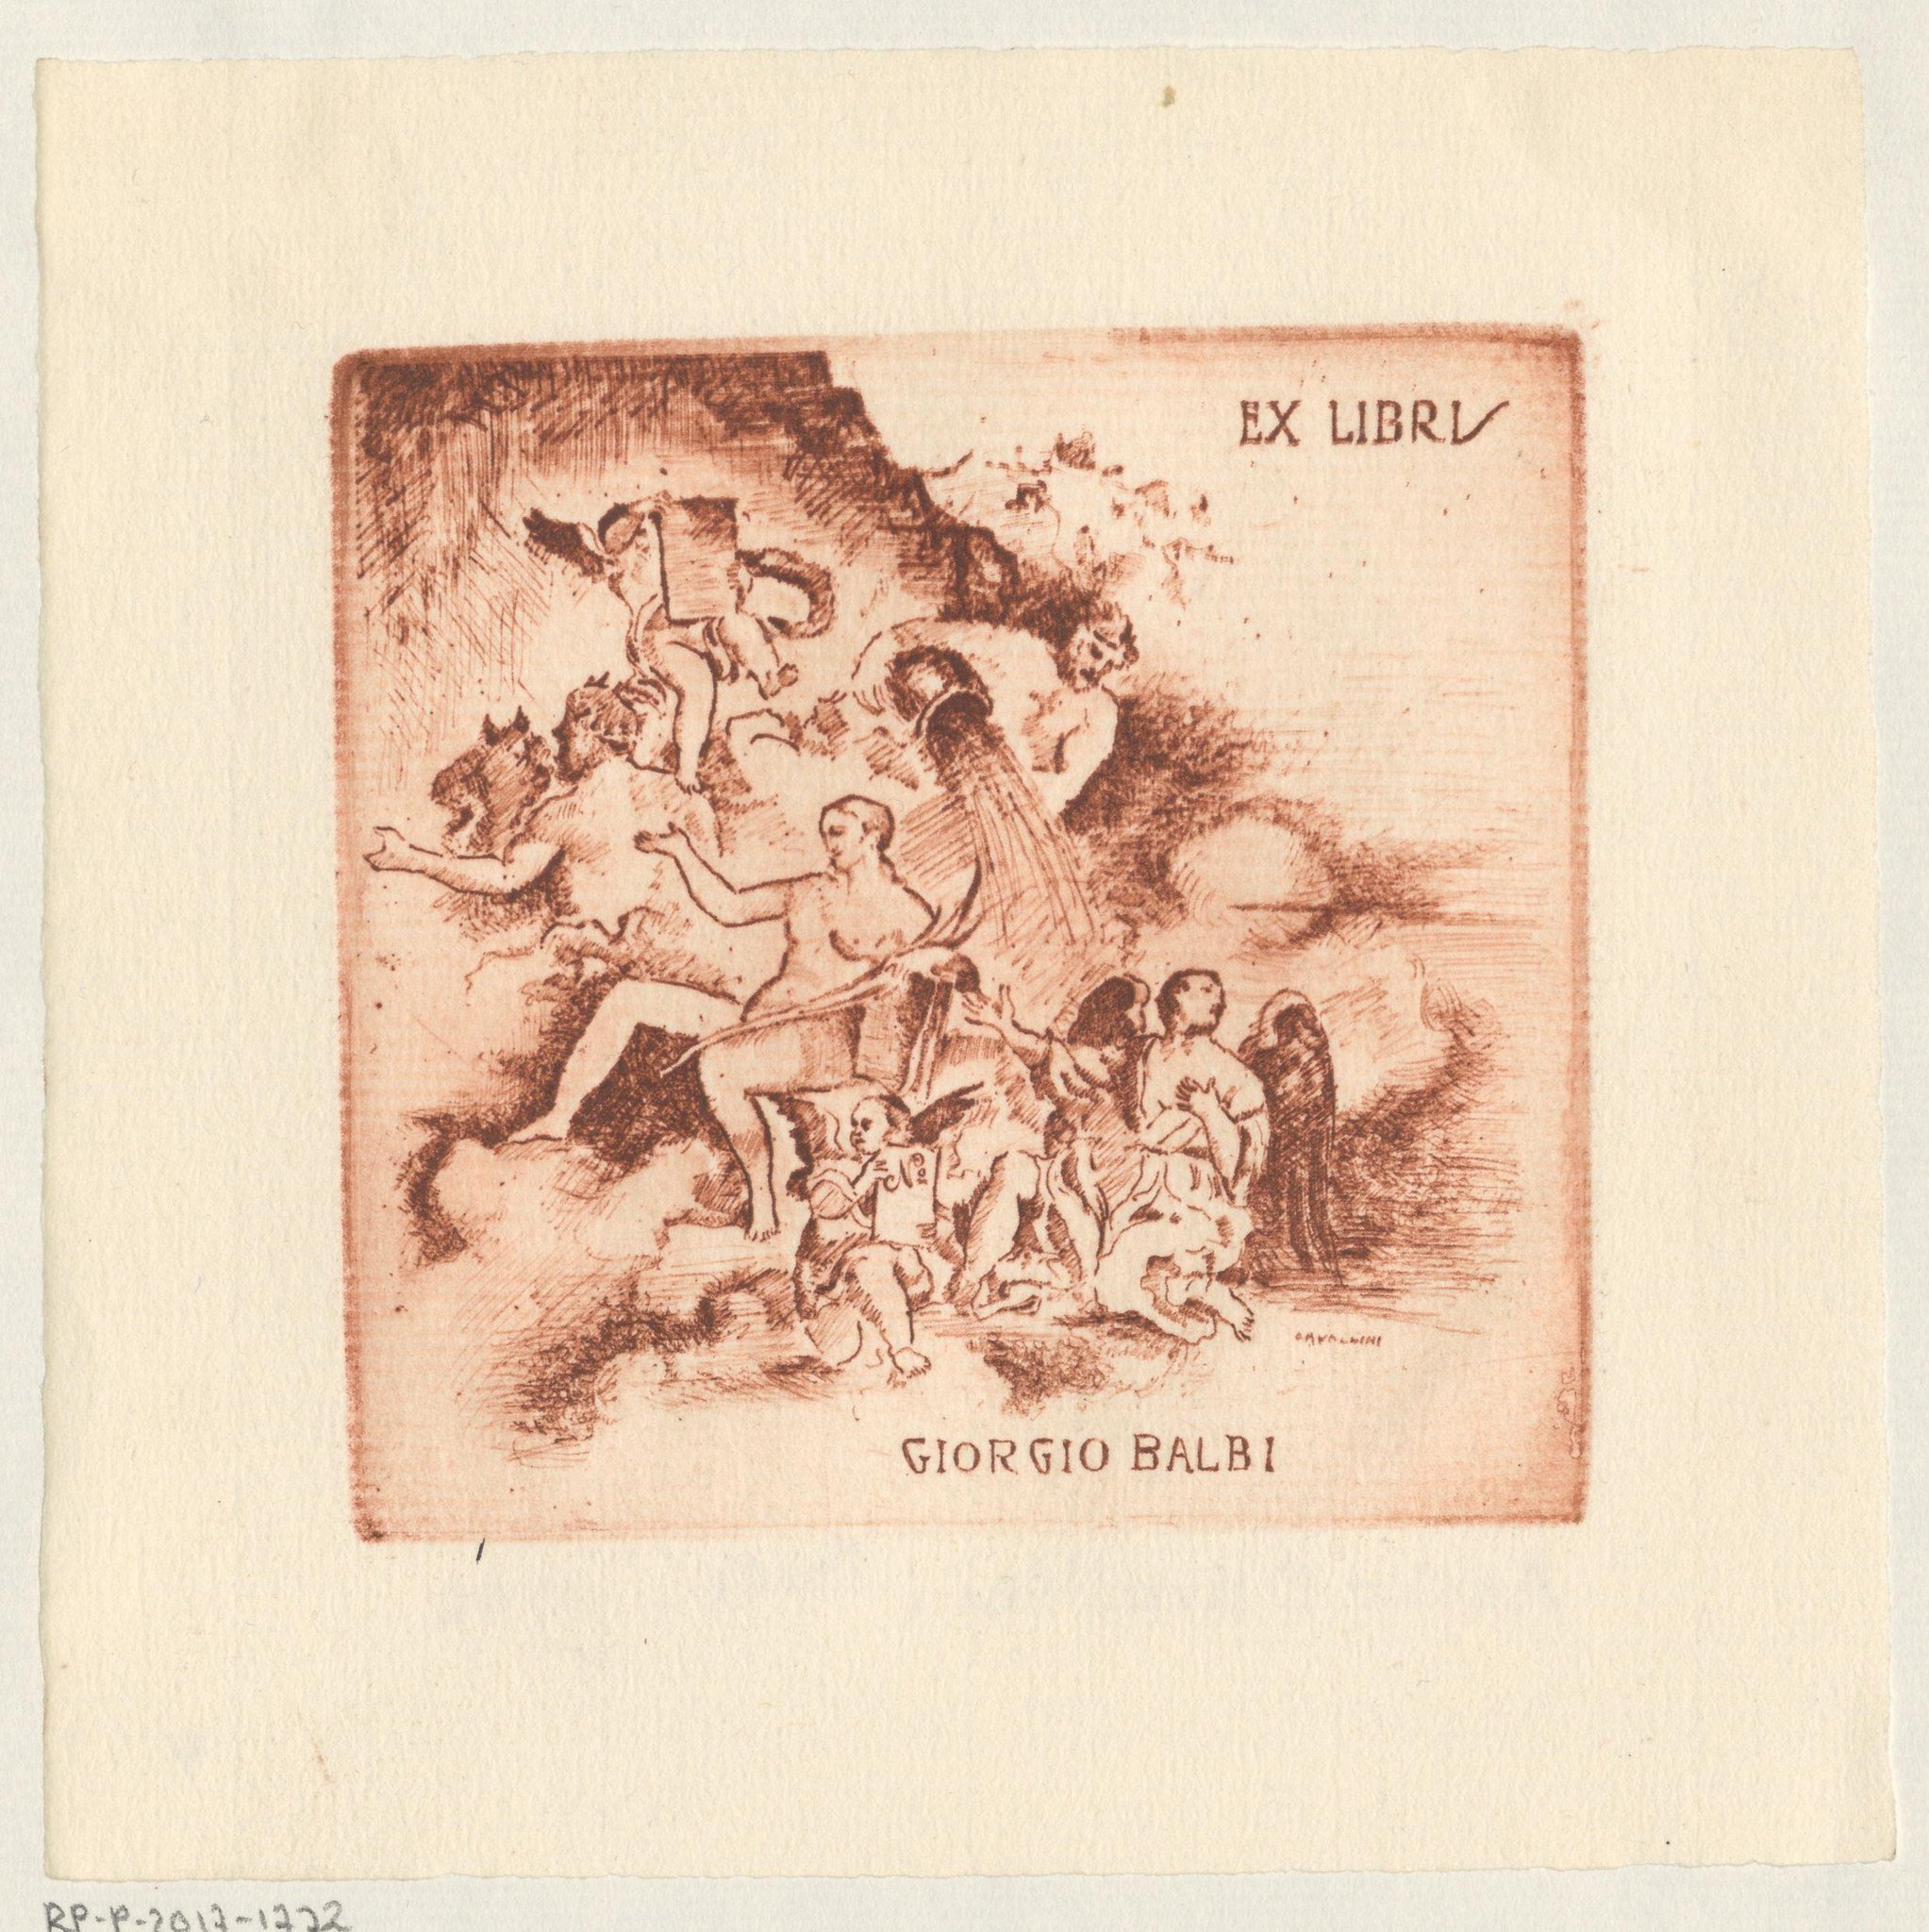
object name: bookplate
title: Ex libris van Giorgio Balbi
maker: attilio cavallini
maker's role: painter, print maker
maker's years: 1888-1946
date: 1942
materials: paper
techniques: etching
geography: italy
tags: woman (showing herself) undressed, quasi-nude, book, cupids: 'amores', 'amoretti', 'putti', angels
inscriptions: inscription: ‘Attilio Cavallini, Italie 1942’